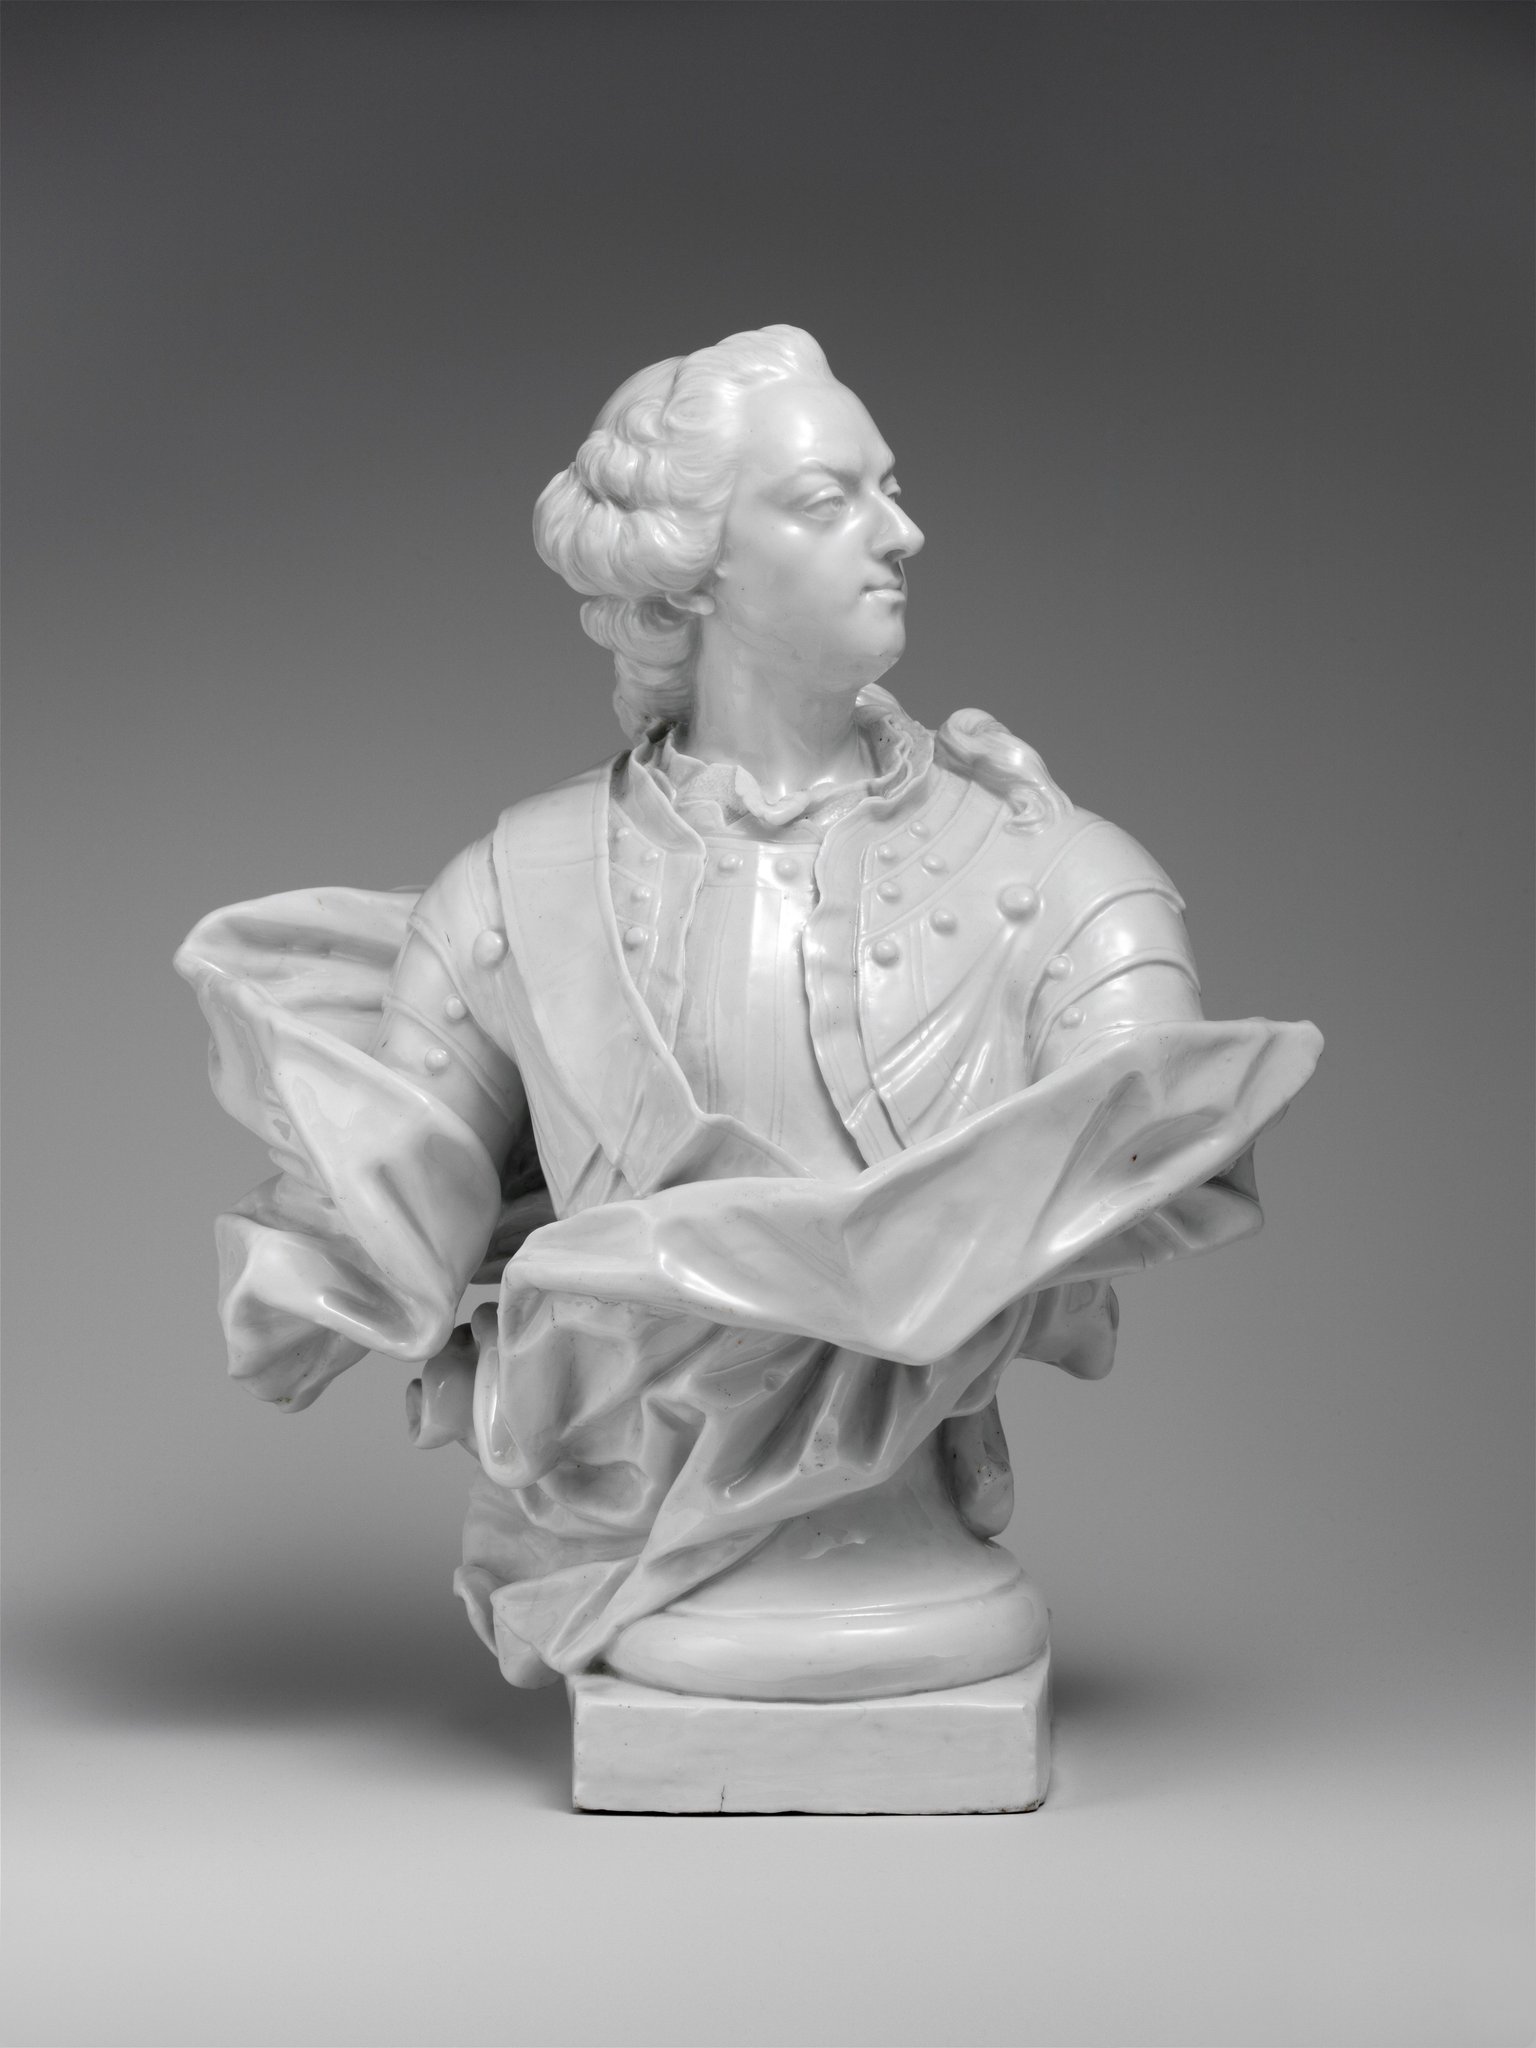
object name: bust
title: Louis XV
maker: tournai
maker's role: factory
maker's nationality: belgian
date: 1756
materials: soft paste porcelain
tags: men